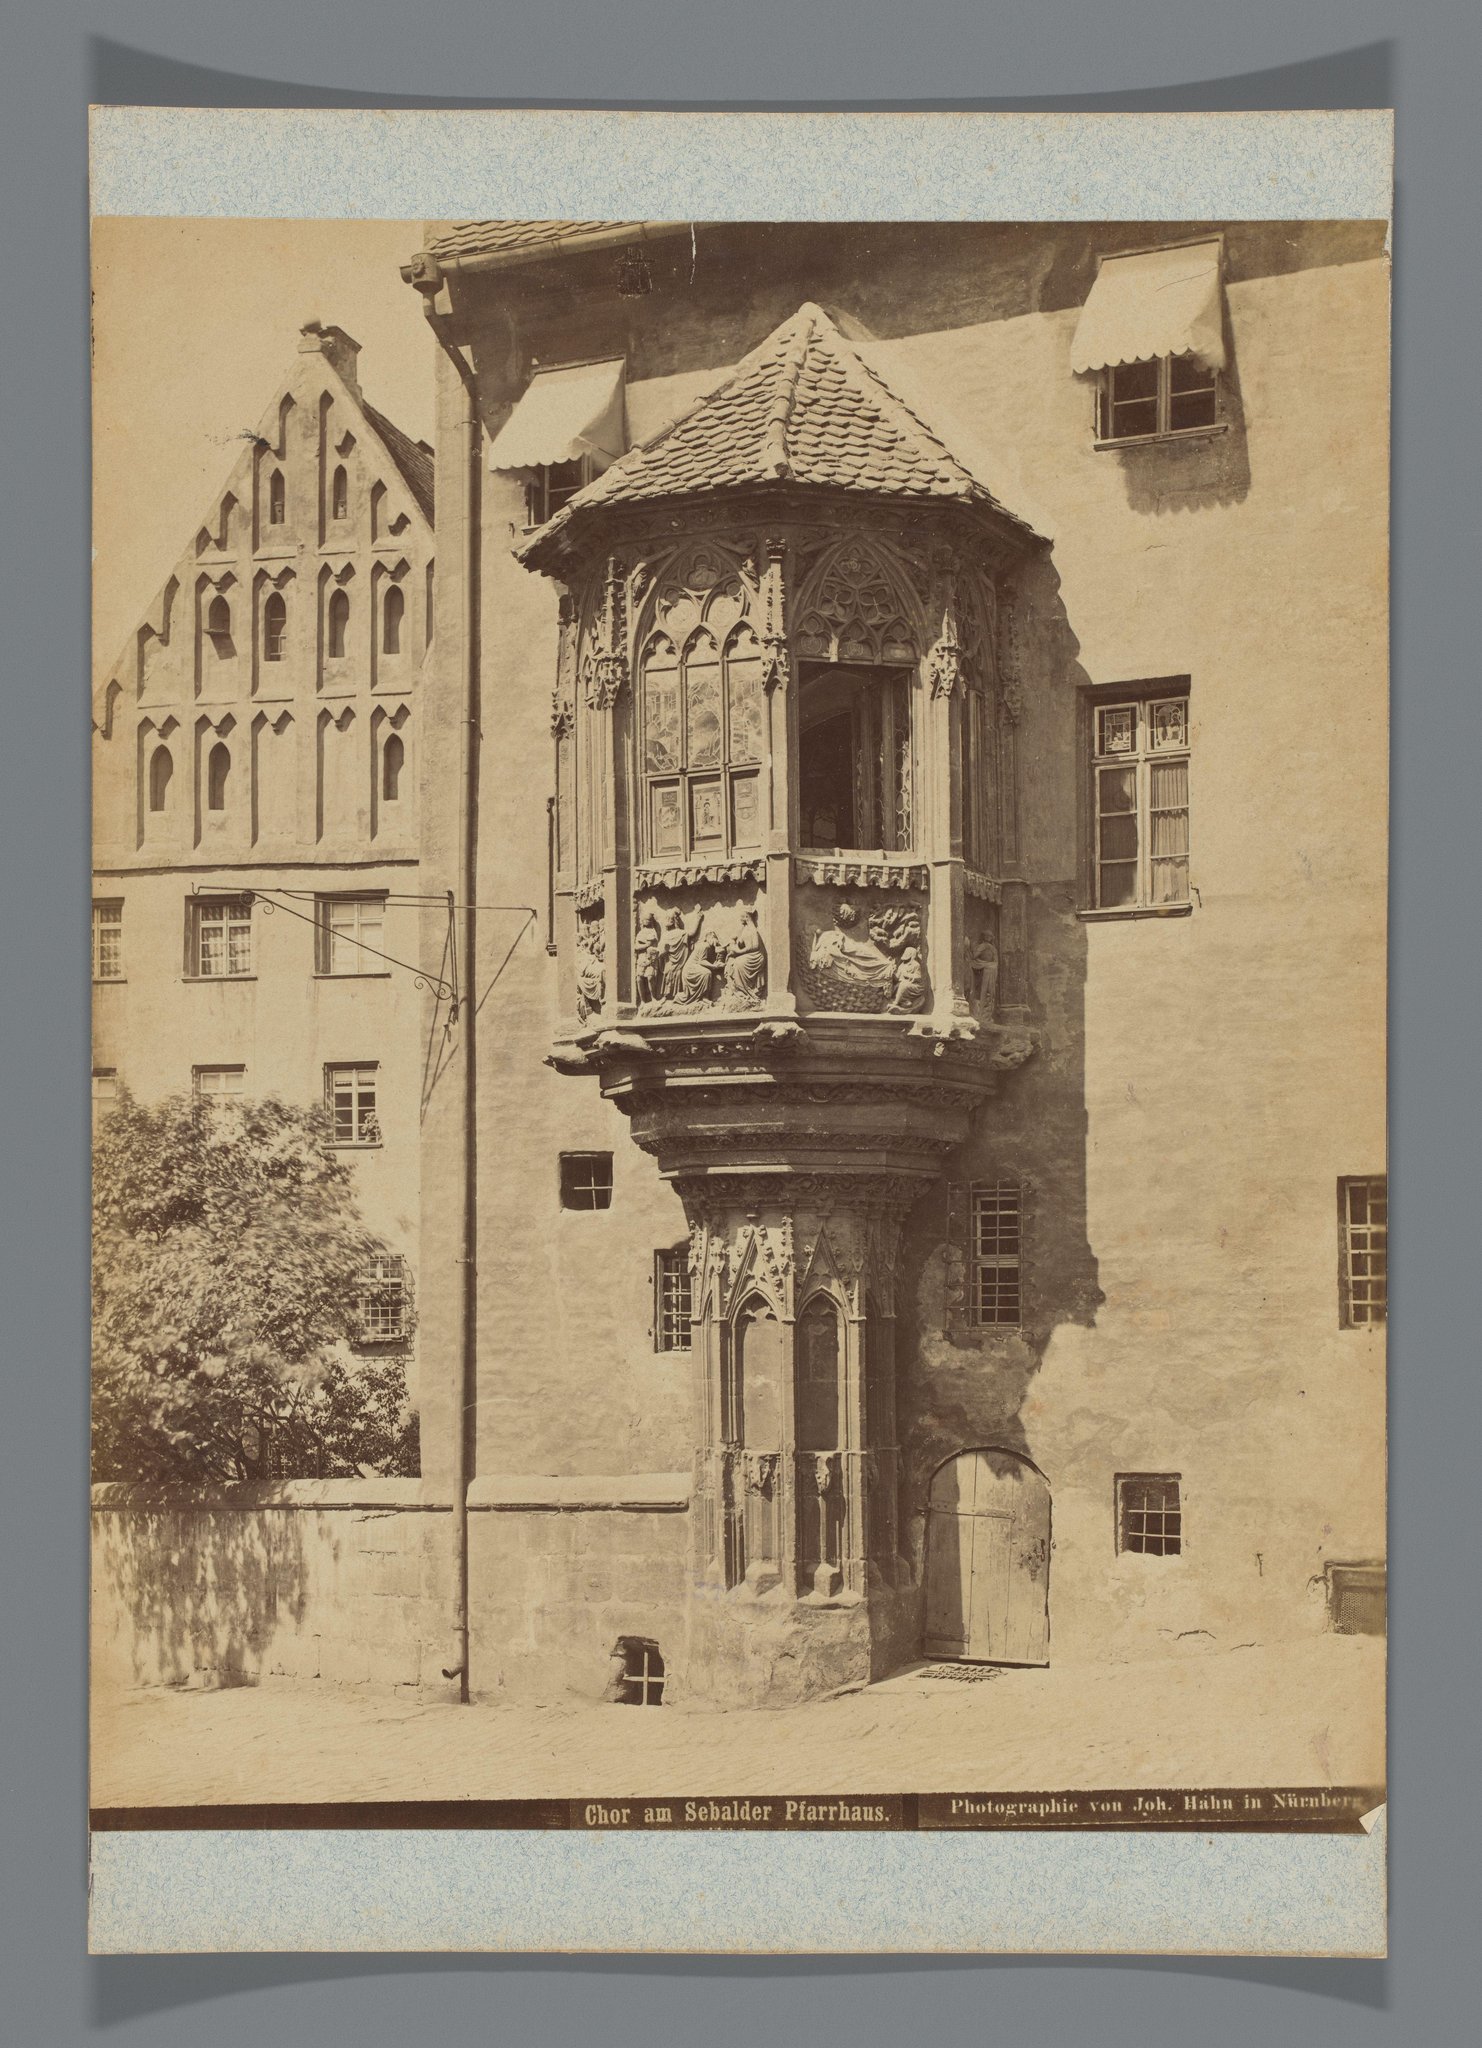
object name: photograph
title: Neurenberg, Chor am Sebalder Pfarrhaus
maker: johannes hahn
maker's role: fotograaf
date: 1850-1900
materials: cardboard, photographic support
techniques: albumen print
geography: berlin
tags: neurenberg